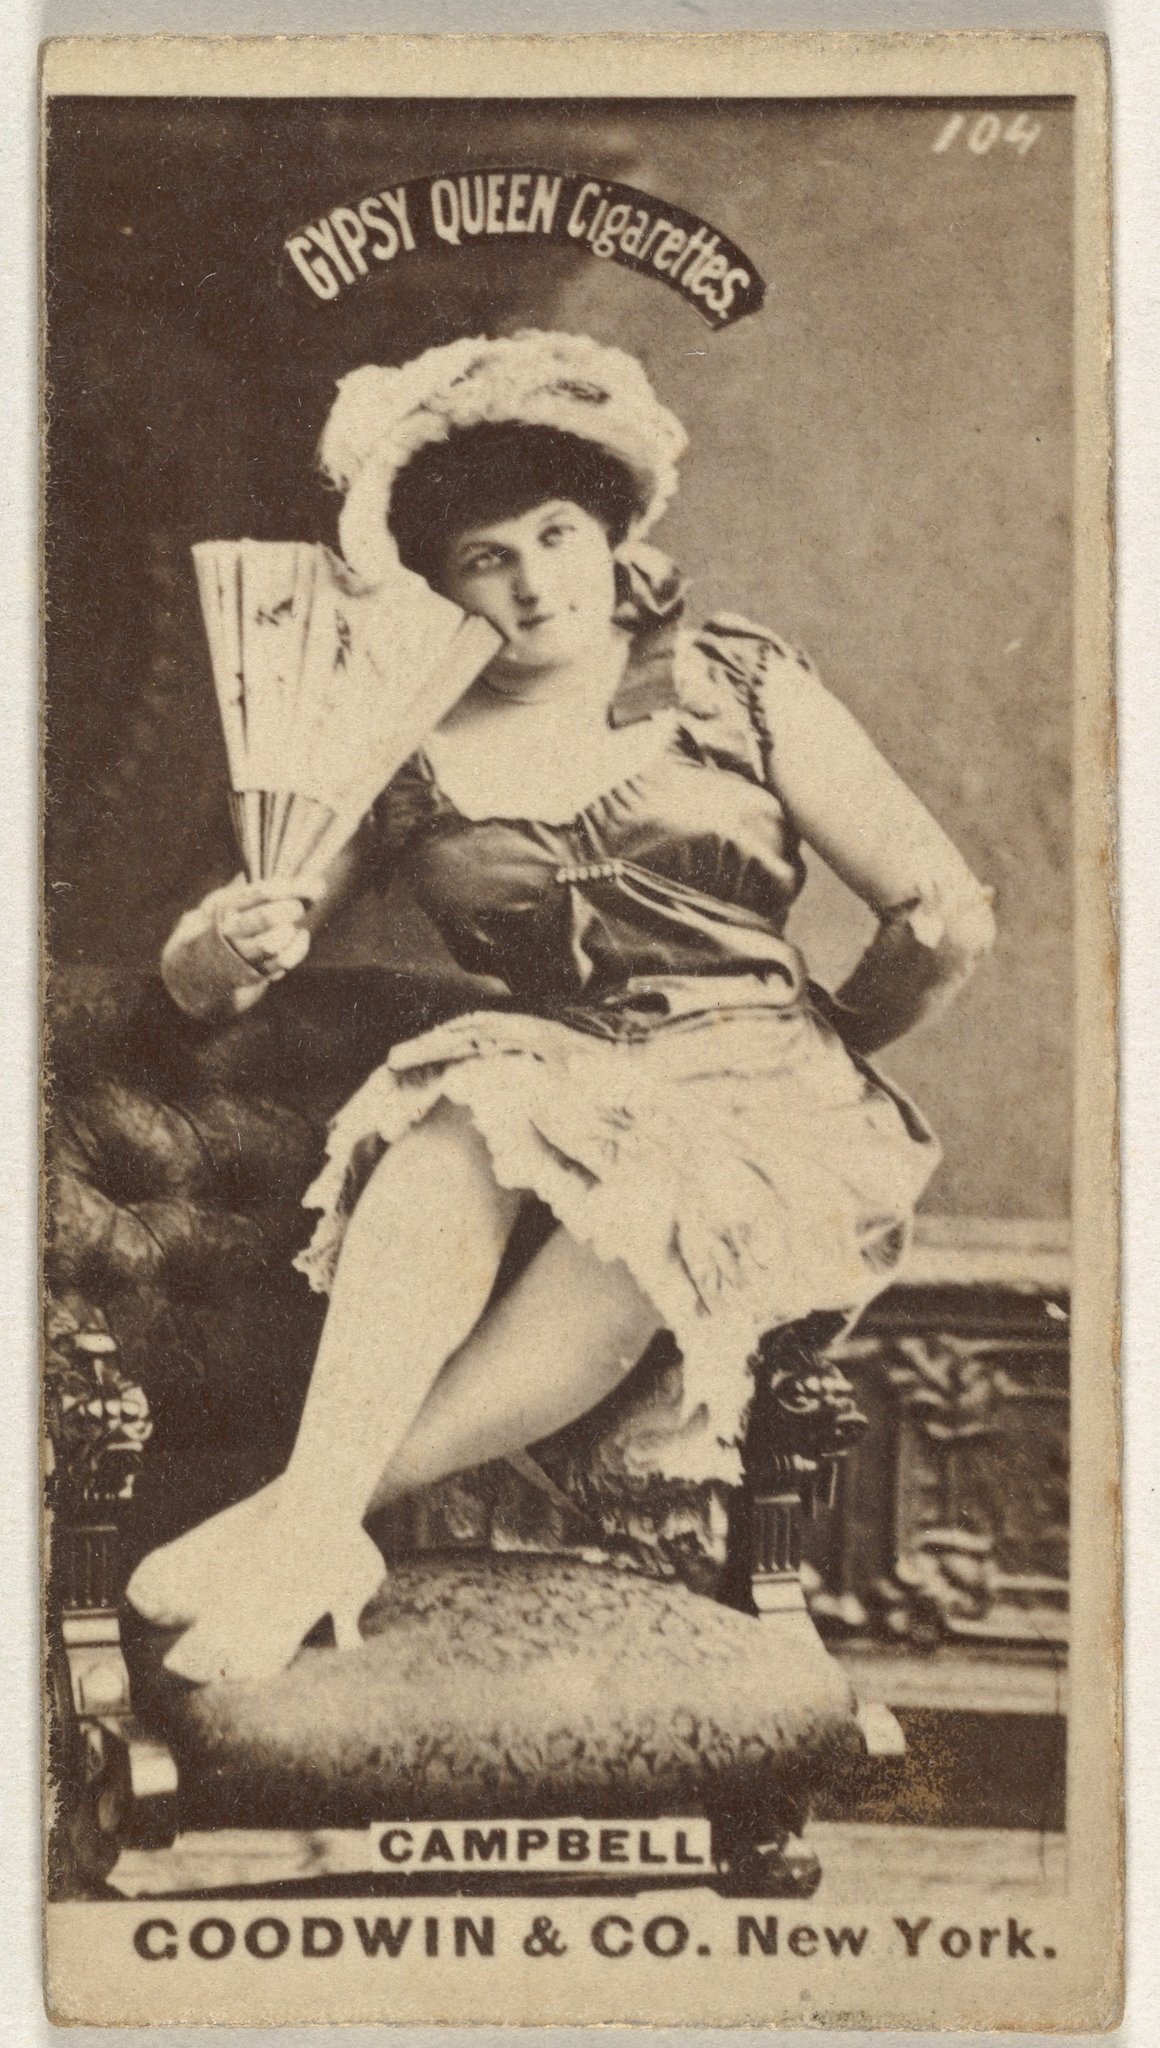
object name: photograph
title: Campbell, from the Actors and Actresses series (N171) for Gypsy Queen Cigarettes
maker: goodwin & company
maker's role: publisher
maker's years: 1850-1950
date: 1886-1890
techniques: albumen silver print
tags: portraits,women,actresses